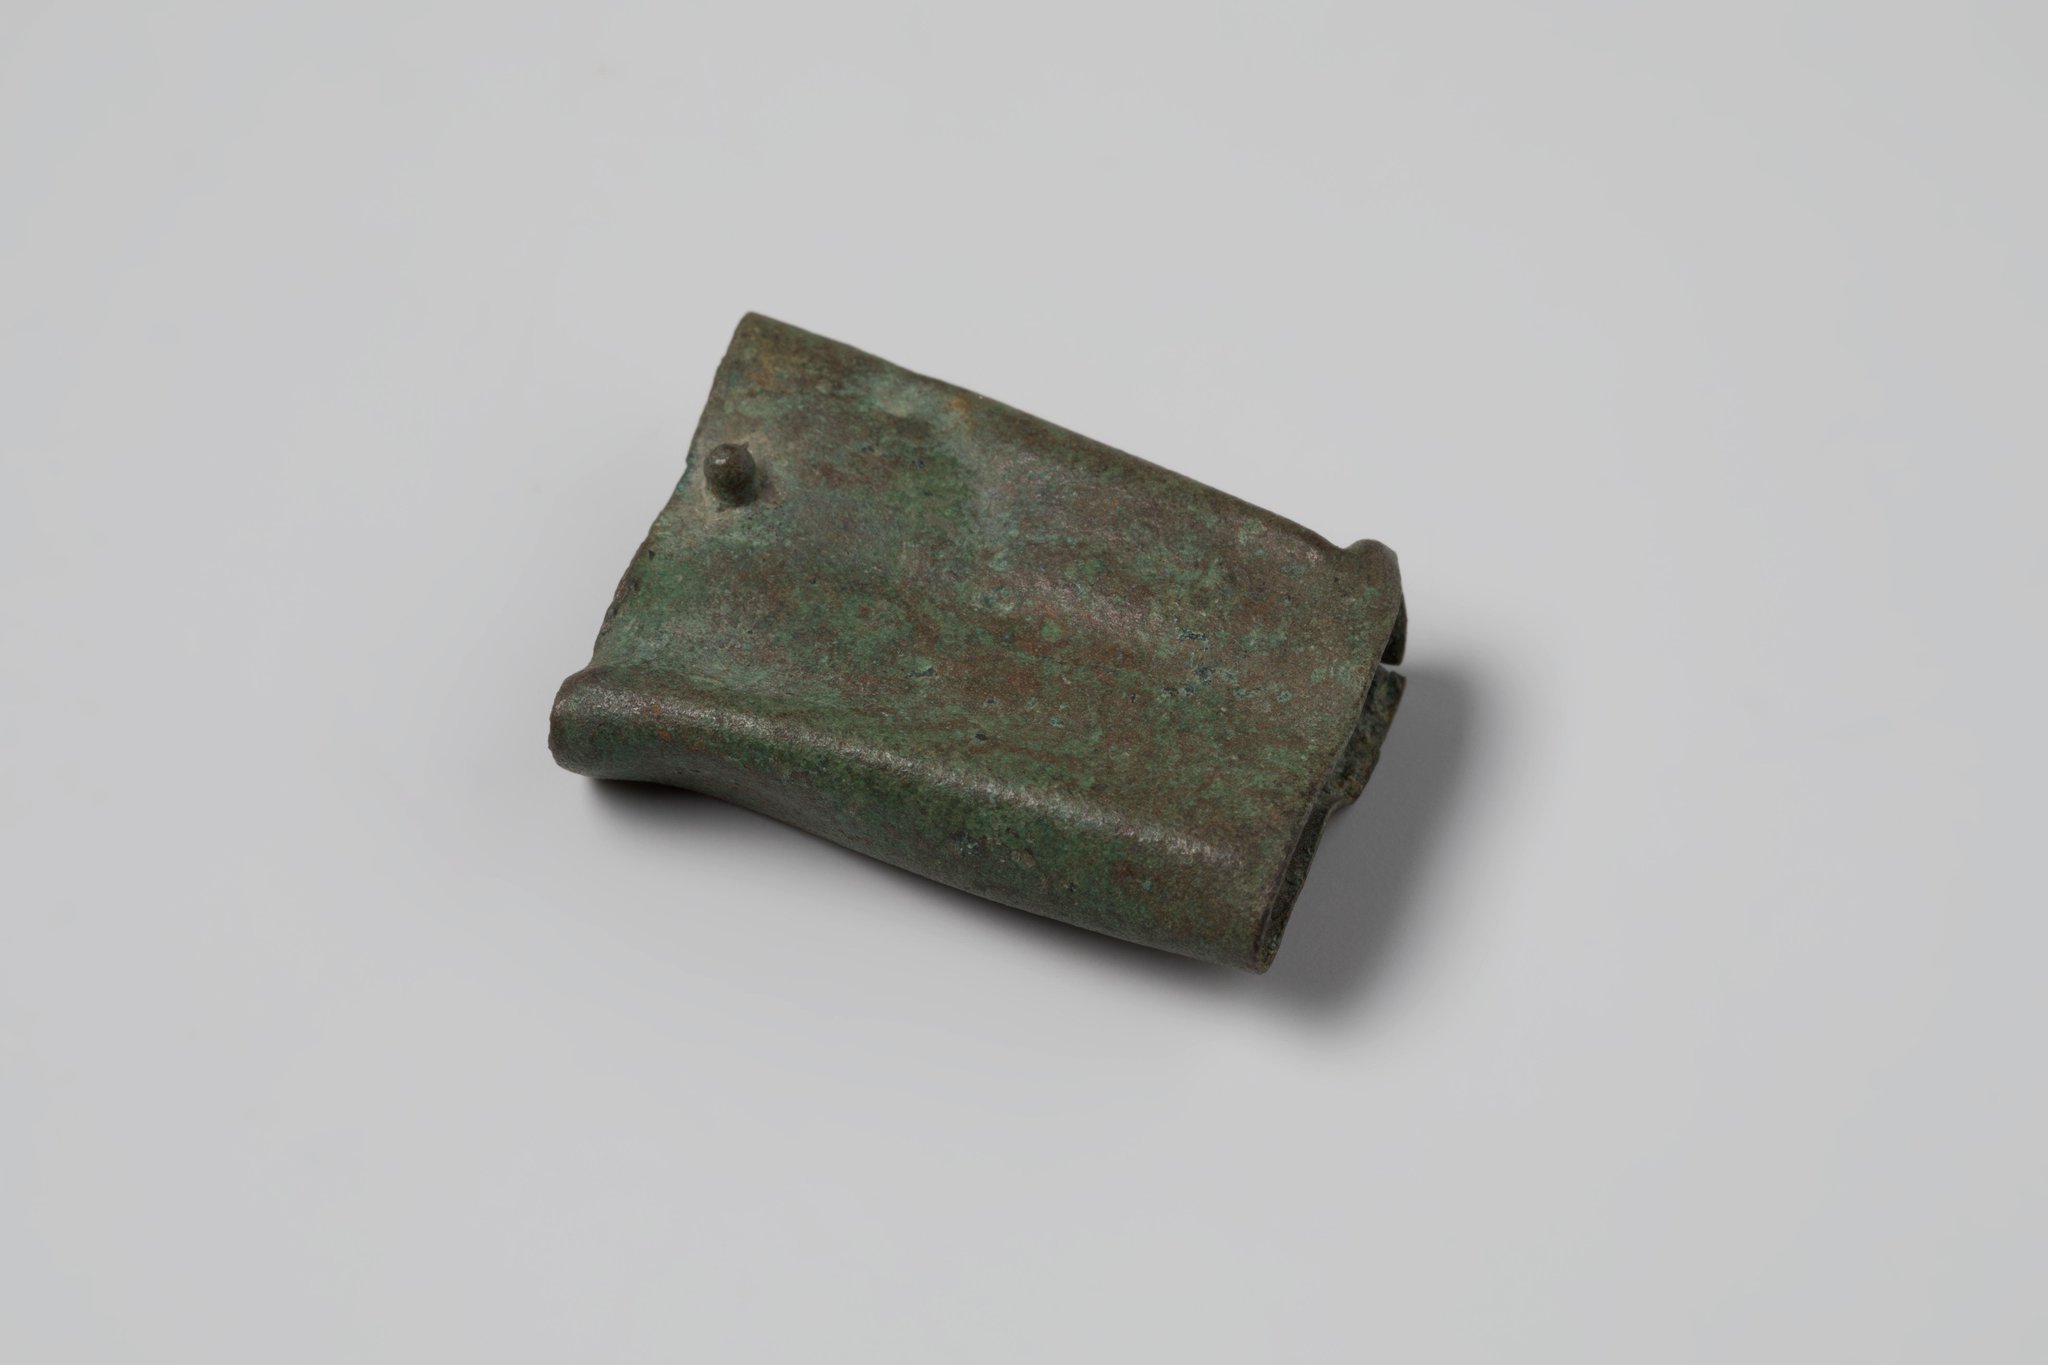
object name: ferrule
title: Beslagring uit het wrak van de Oost-Indiëvaarder Hollandia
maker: Anonymous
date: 1700-1743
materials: copper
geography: netherlands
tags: verenigde oostindische compagnie, hollandia (schip), annet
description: Fittings, bands and bracing, conical; squashed, longitudinal soldered seam broken, short threaded pin fitted in rim.